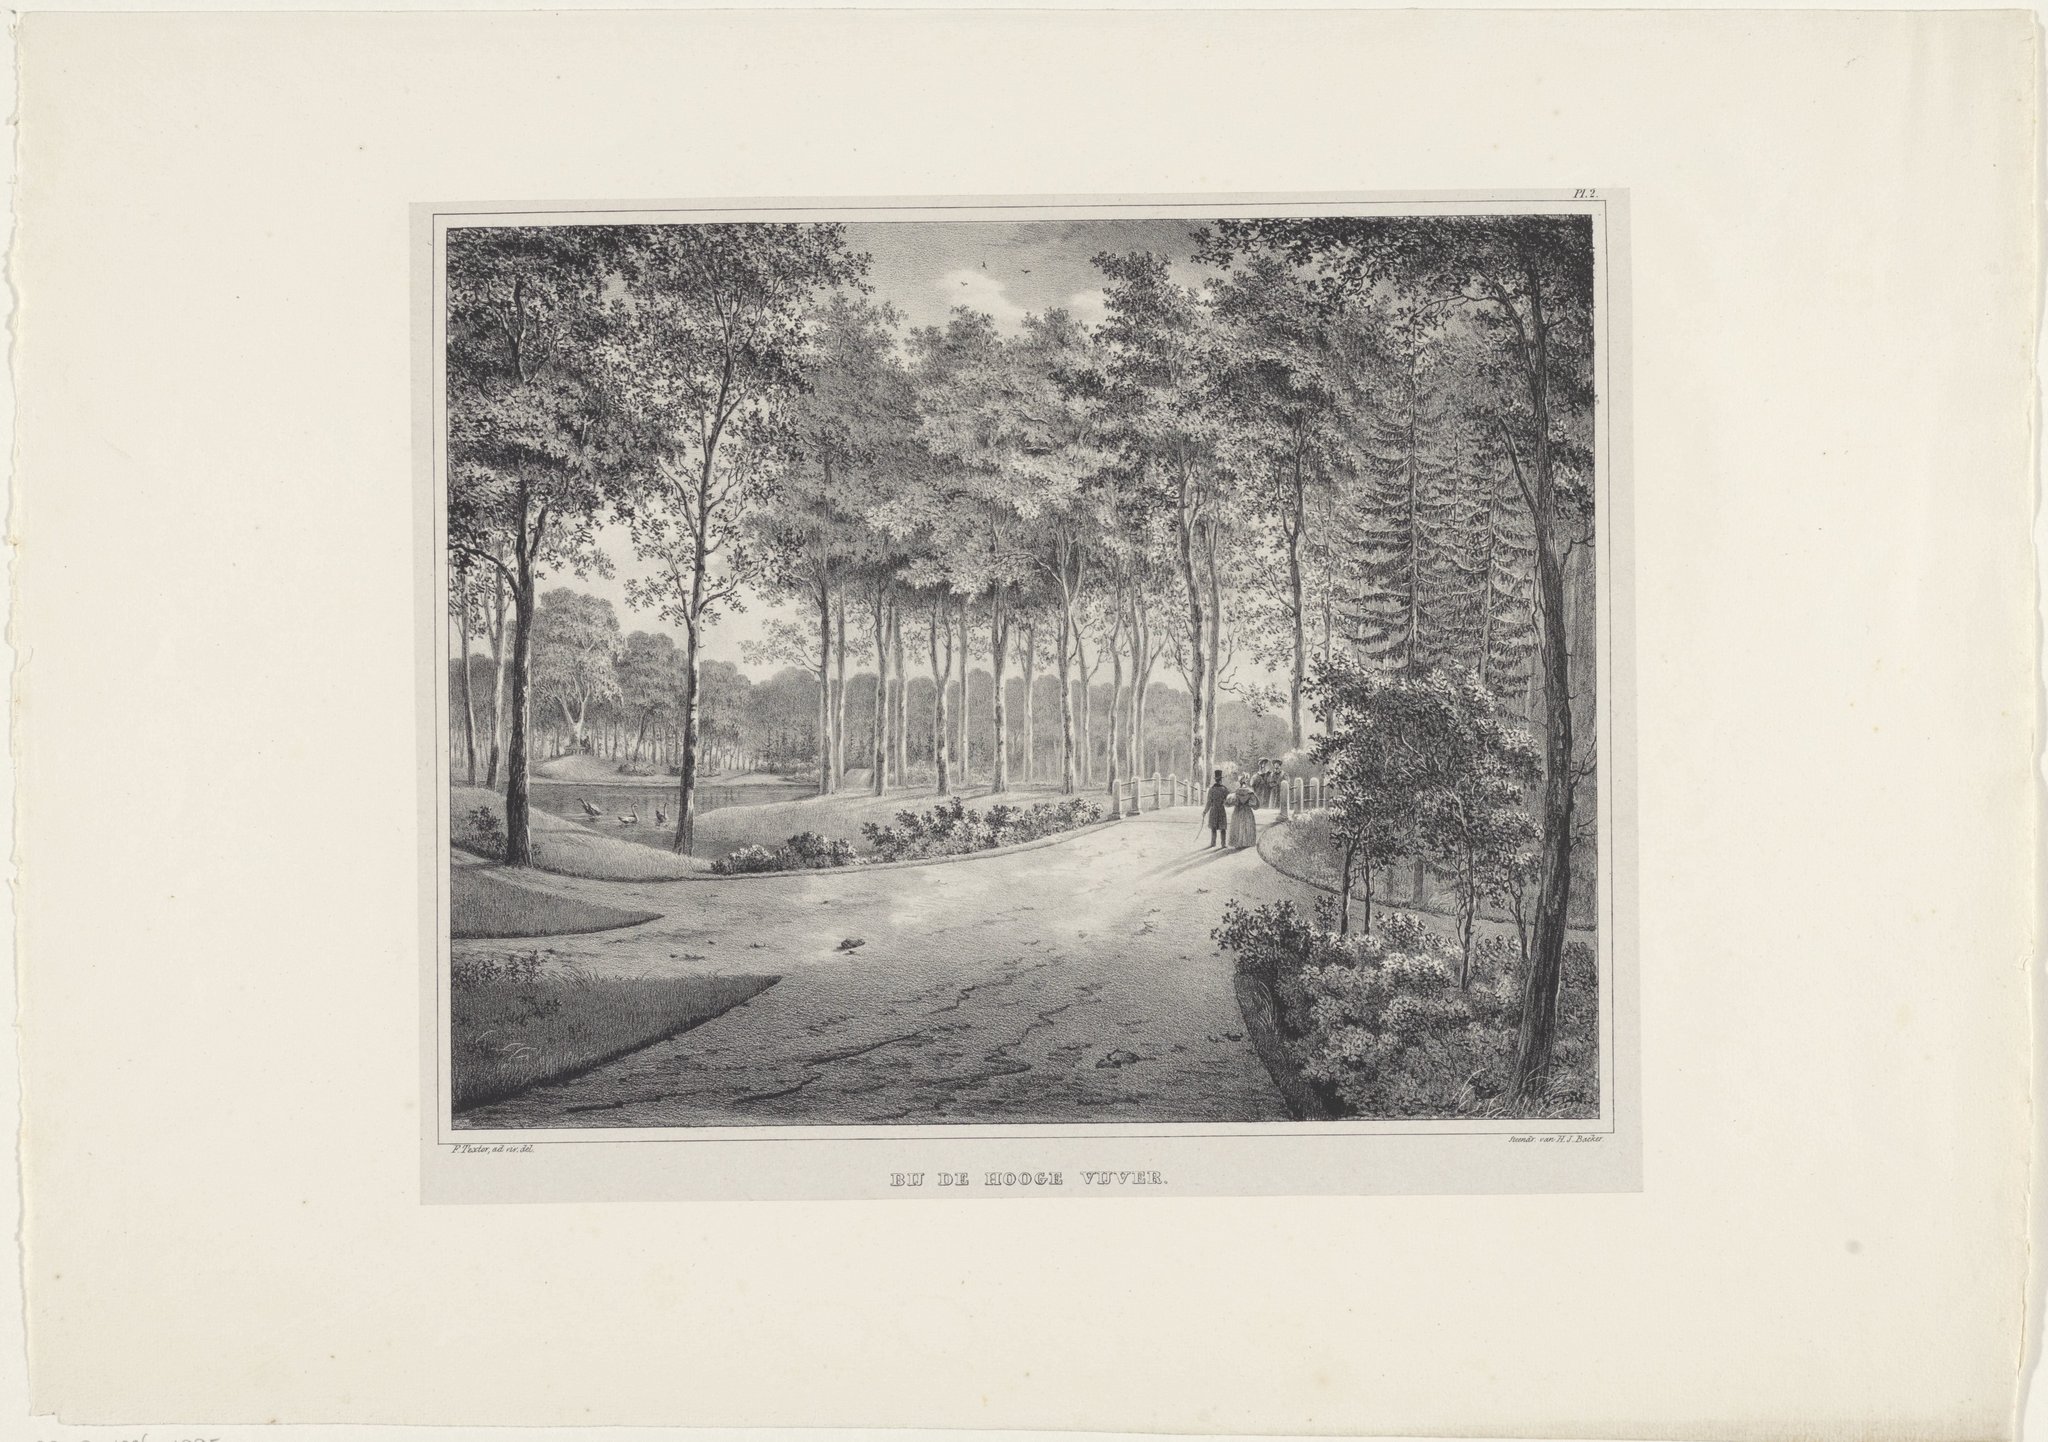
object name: print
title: XII Gezigten in het Park Het Loo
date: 1822-1845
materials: paper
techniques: lithograph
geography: apeldoorn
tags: arm in arm (friends), water-birds: swan, garden pond, arm in arm (lovers)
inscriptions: collector's mark: Lugt 2228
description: Links in de vijver zwemmen drie zwanen. Over de brug lopen een man en vrouw arm in arm. Twee vrouwen komen hen tegemoet. Genummerd rechtsboven: Pl. 2.